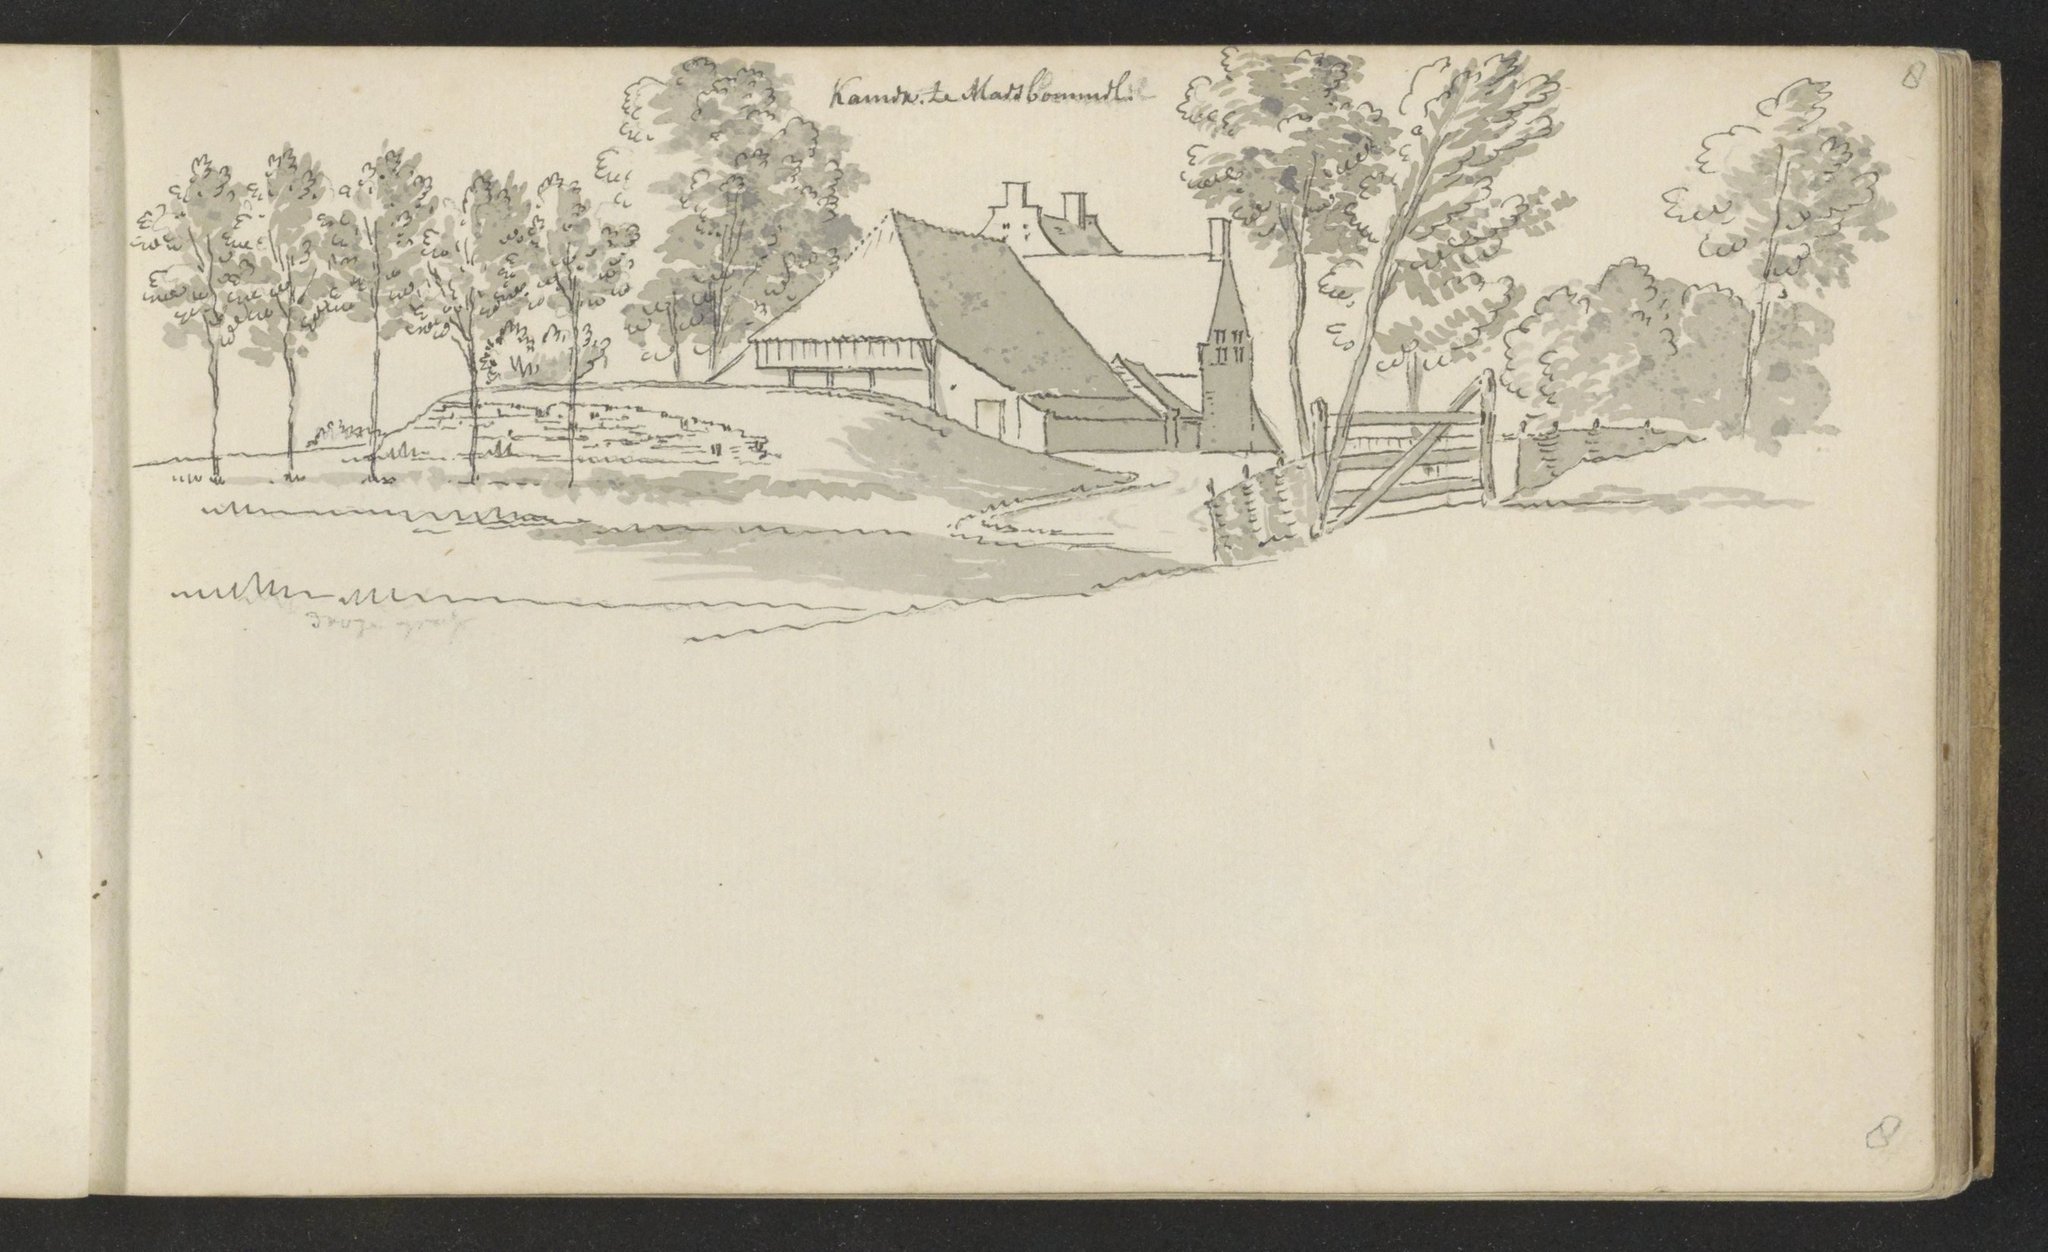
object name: sketchbook leaf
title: Bouwwerk te Maasbommel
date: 1701-1759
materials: ink, paper, pencil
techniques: brush, pen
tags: city-view, and landscape with man-made constructions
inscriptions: annotation: ‘Kam[..] te Maasbommel’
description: Blad 8 recto uit een schetsboek met 65 bladen.